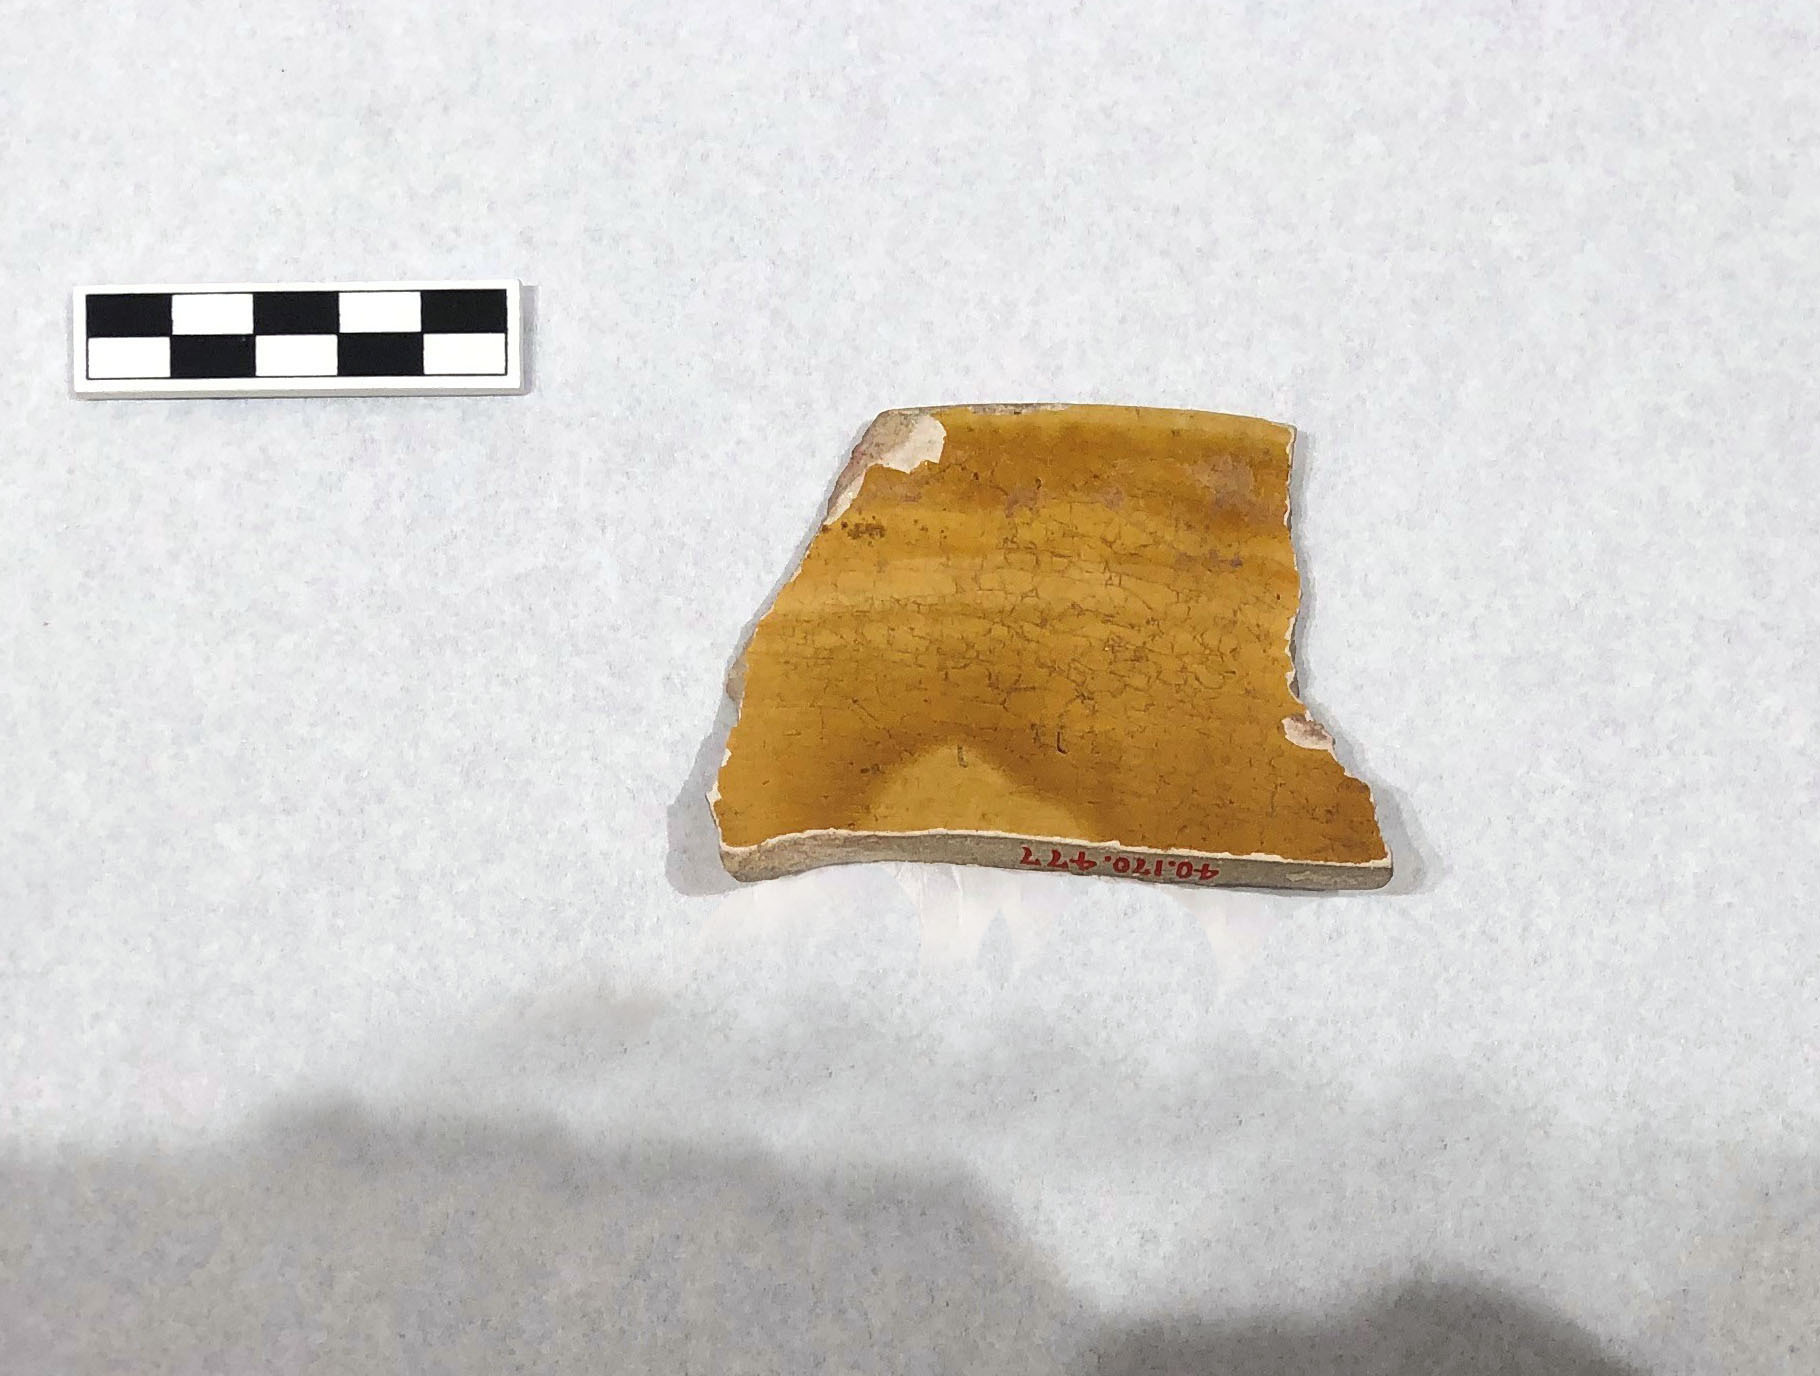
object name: fragment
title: Ceamic Fragment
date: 801-900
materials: earthenware, glaze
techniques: incising, polychrome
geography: iran